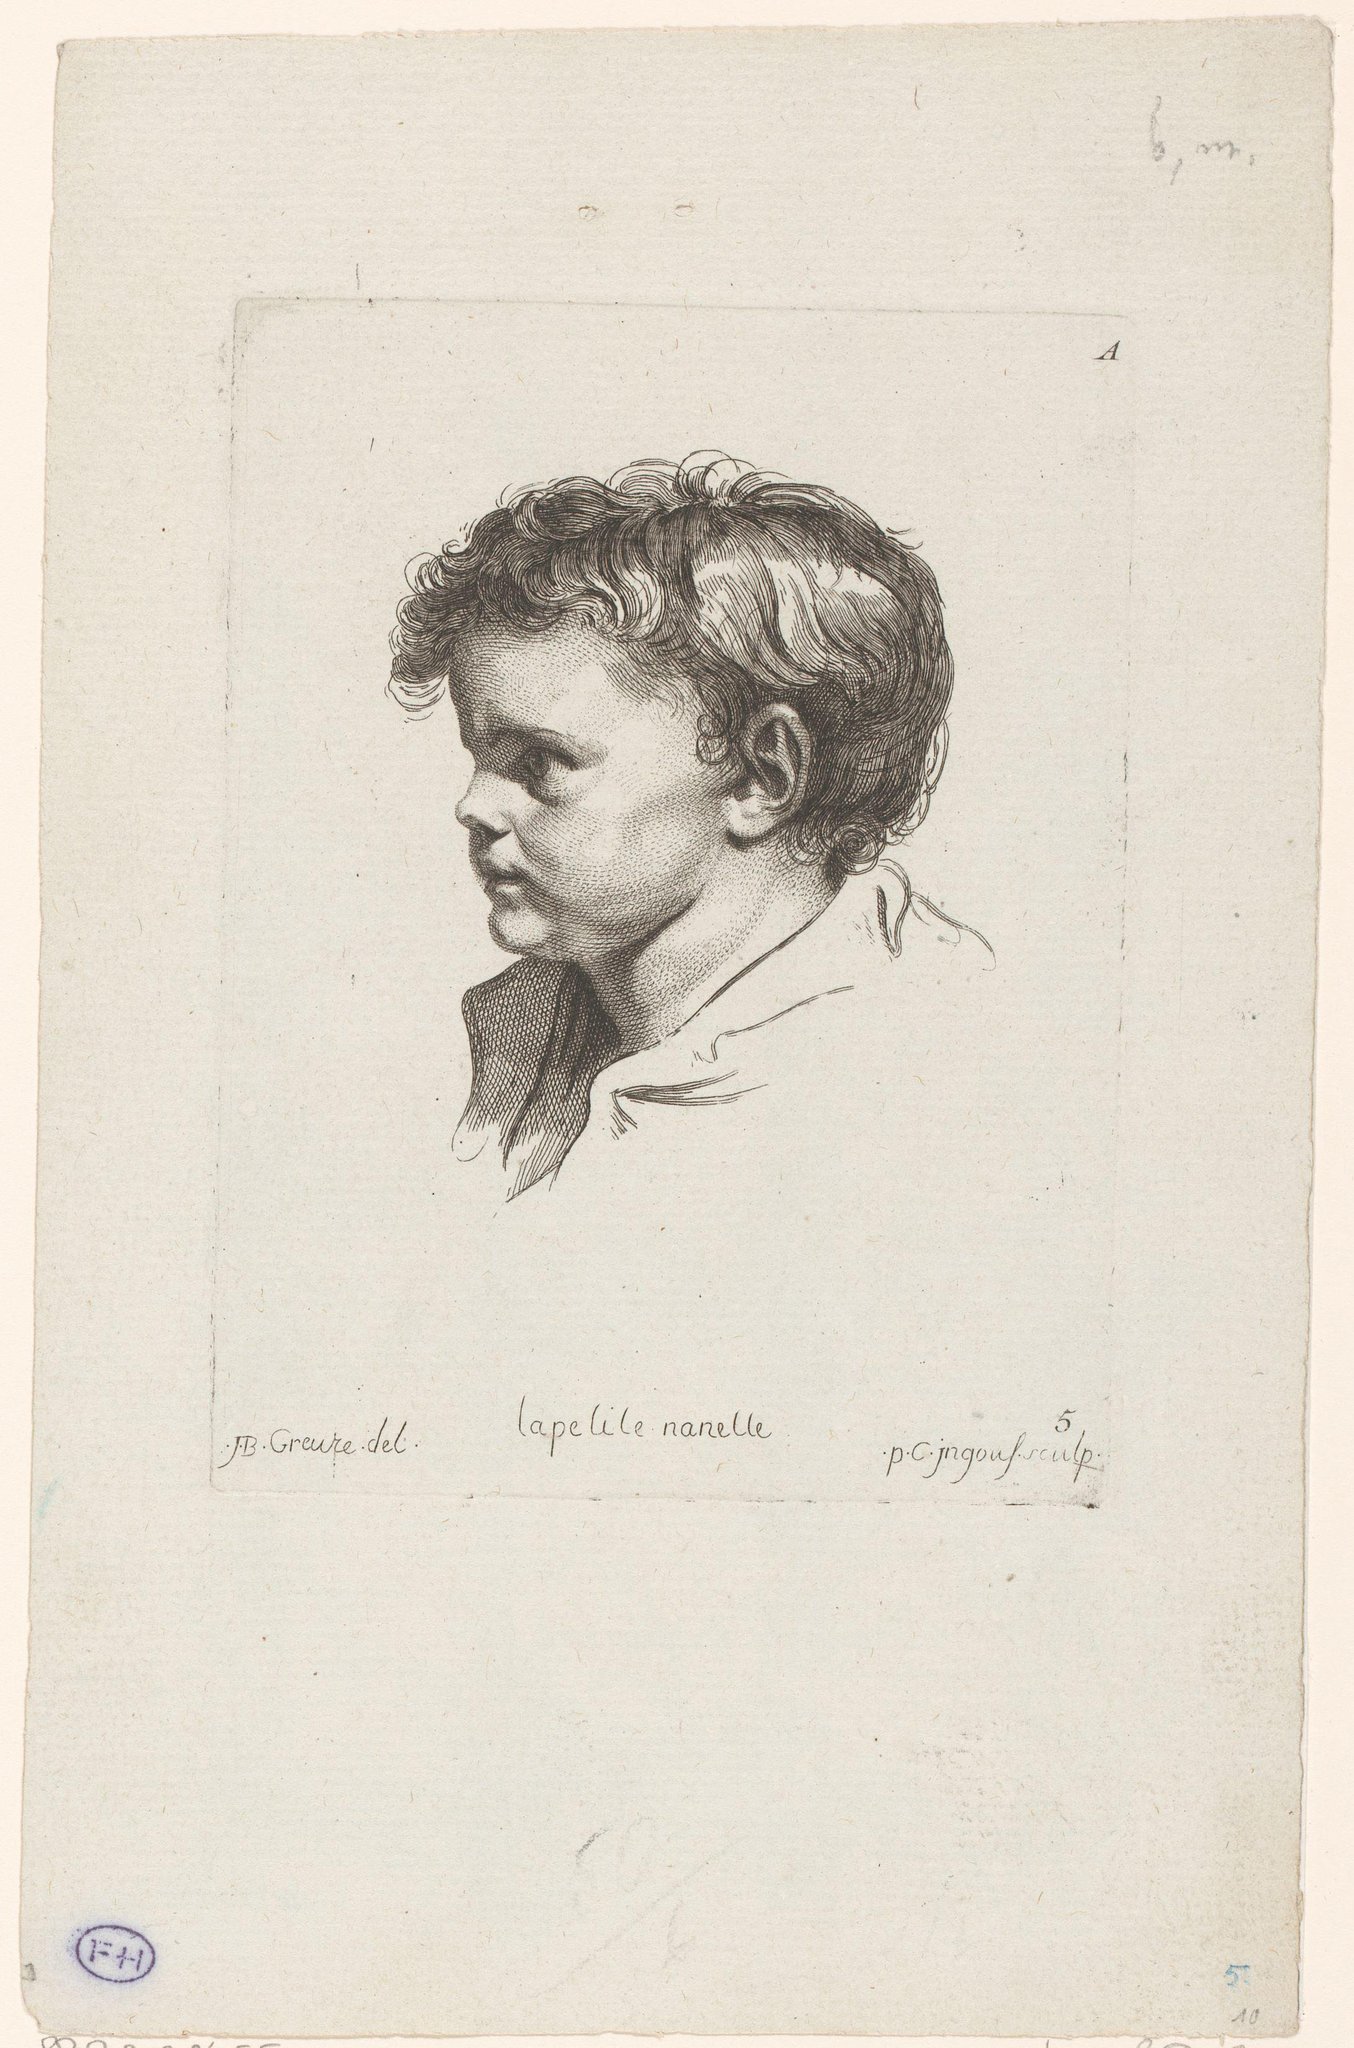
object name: print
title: La petite Nanette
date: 1766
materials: paper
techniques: engraving, etching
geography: paris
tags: child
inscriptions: collector's mark: Lugt 2760, collector's mark: Lugt 3373, number: ‘a // 5’, collector's mark: Lugt 2228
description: Maakt deel uit van een negendelige serie met hoofden van verschillende figuren.